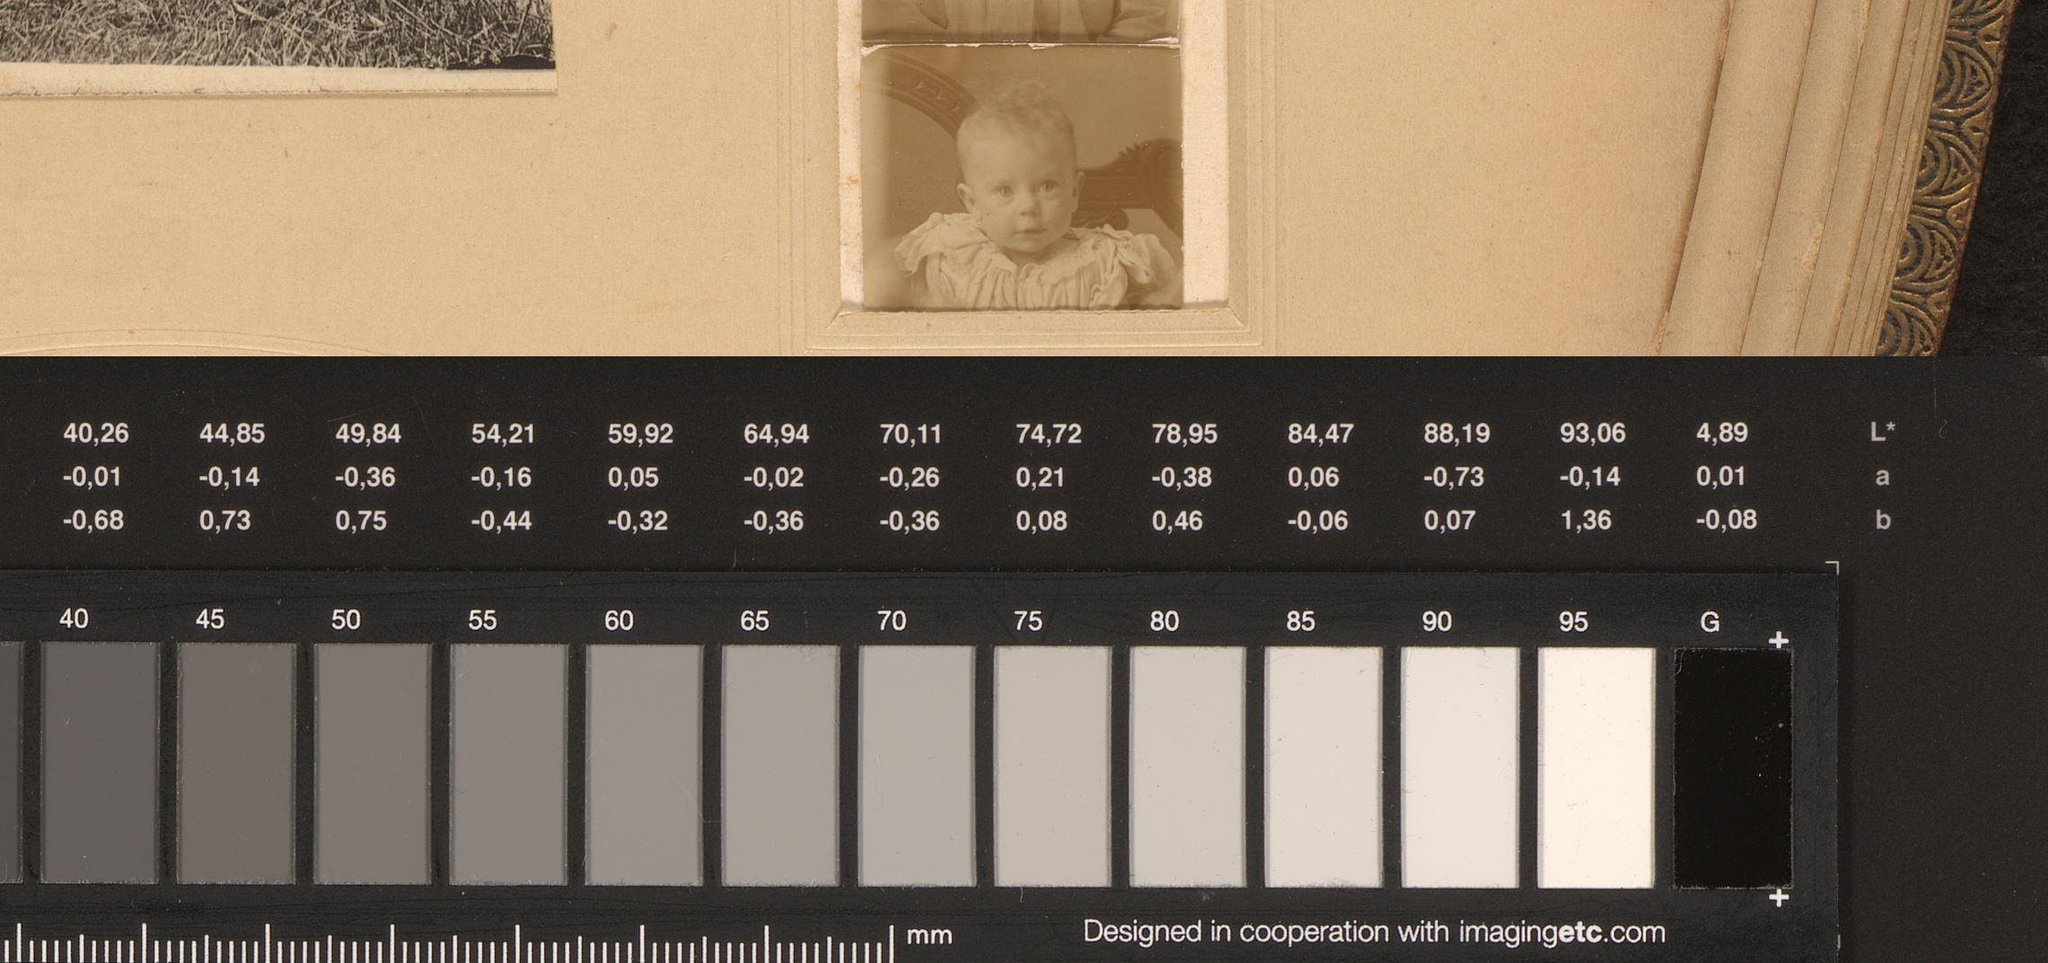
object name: photograph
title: Portret van een baby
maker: Anonymous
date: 1890-1910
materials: cardboard, photographic support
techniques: gelatin silver print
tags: historical persons, infant, baby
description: Deze foto maakt deel uit van een album. Samen met RP-F-F00830-AP in passe-partout.